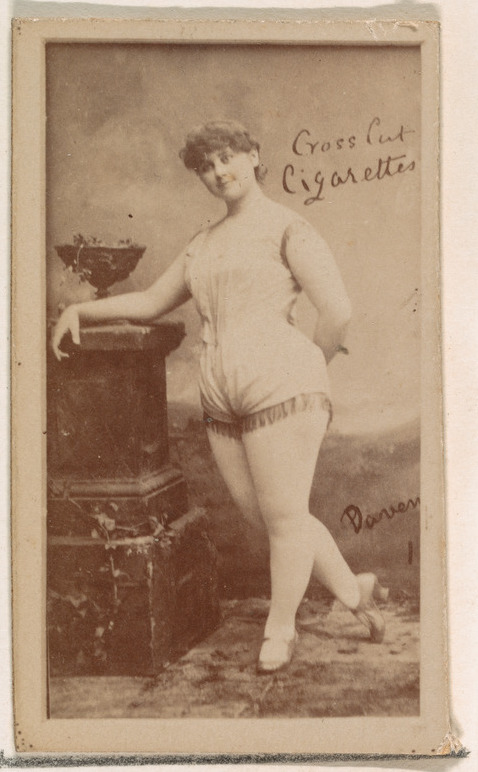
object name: print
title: Davenport, from the Actors and Actresses series (N145-1) issued by Duke Sons & Co. to promote Cross Cut Cigarettes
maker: w. duke, sons & co.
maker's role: publisher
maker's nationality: american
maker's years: 1870-1920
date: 1880-1889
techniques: albumen silver print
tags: portraits,women,actresses